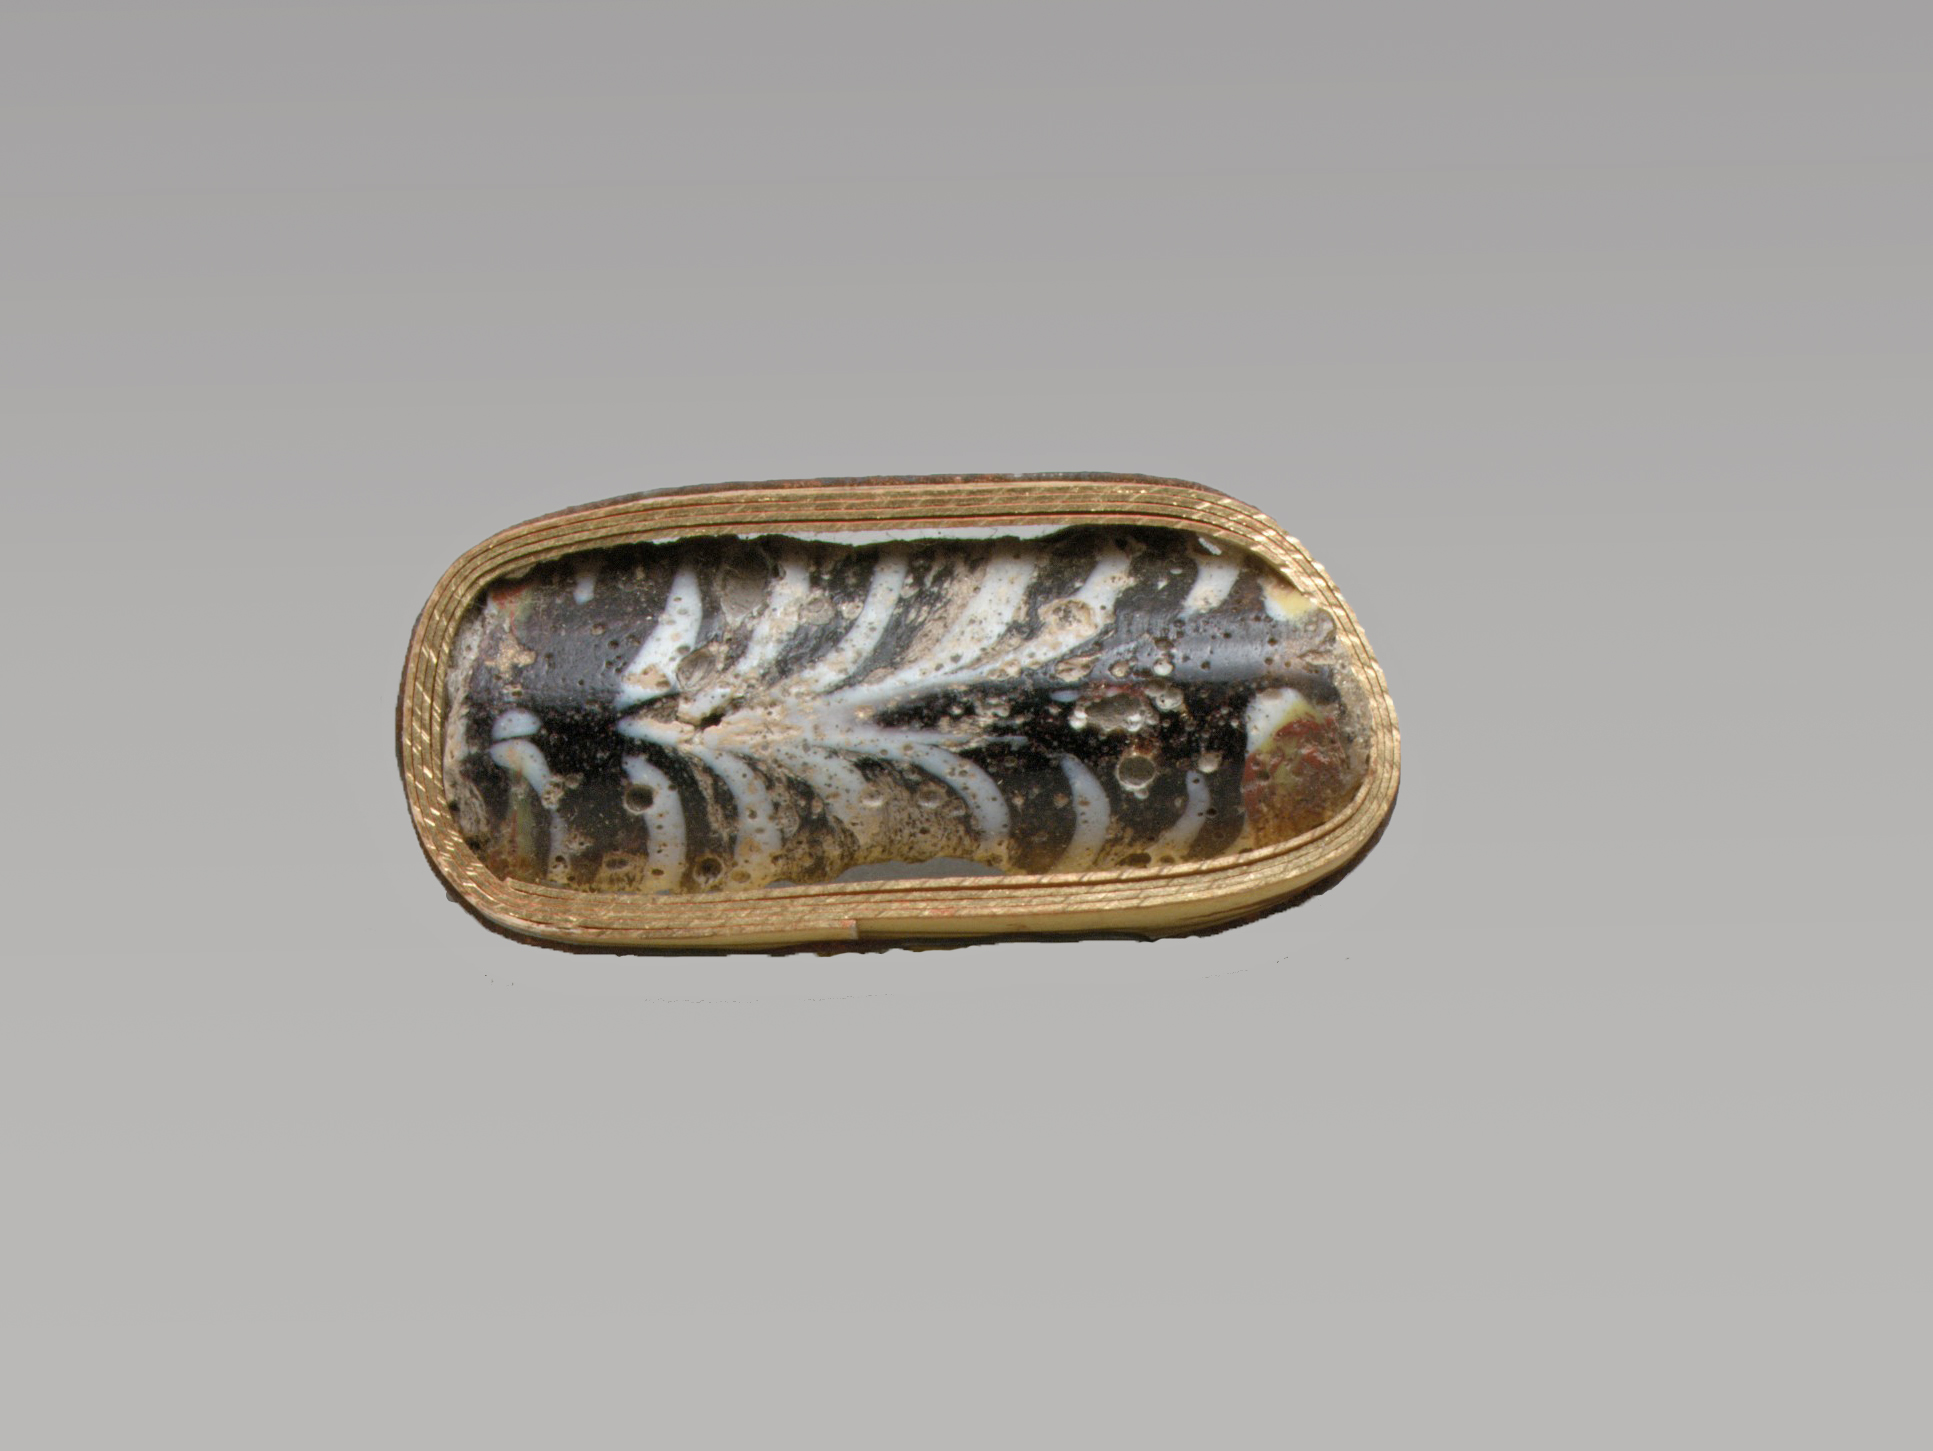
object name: fragment, mosaic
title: Glass mosaic fragment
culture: roman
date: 34 BCE-33 CE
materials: glass